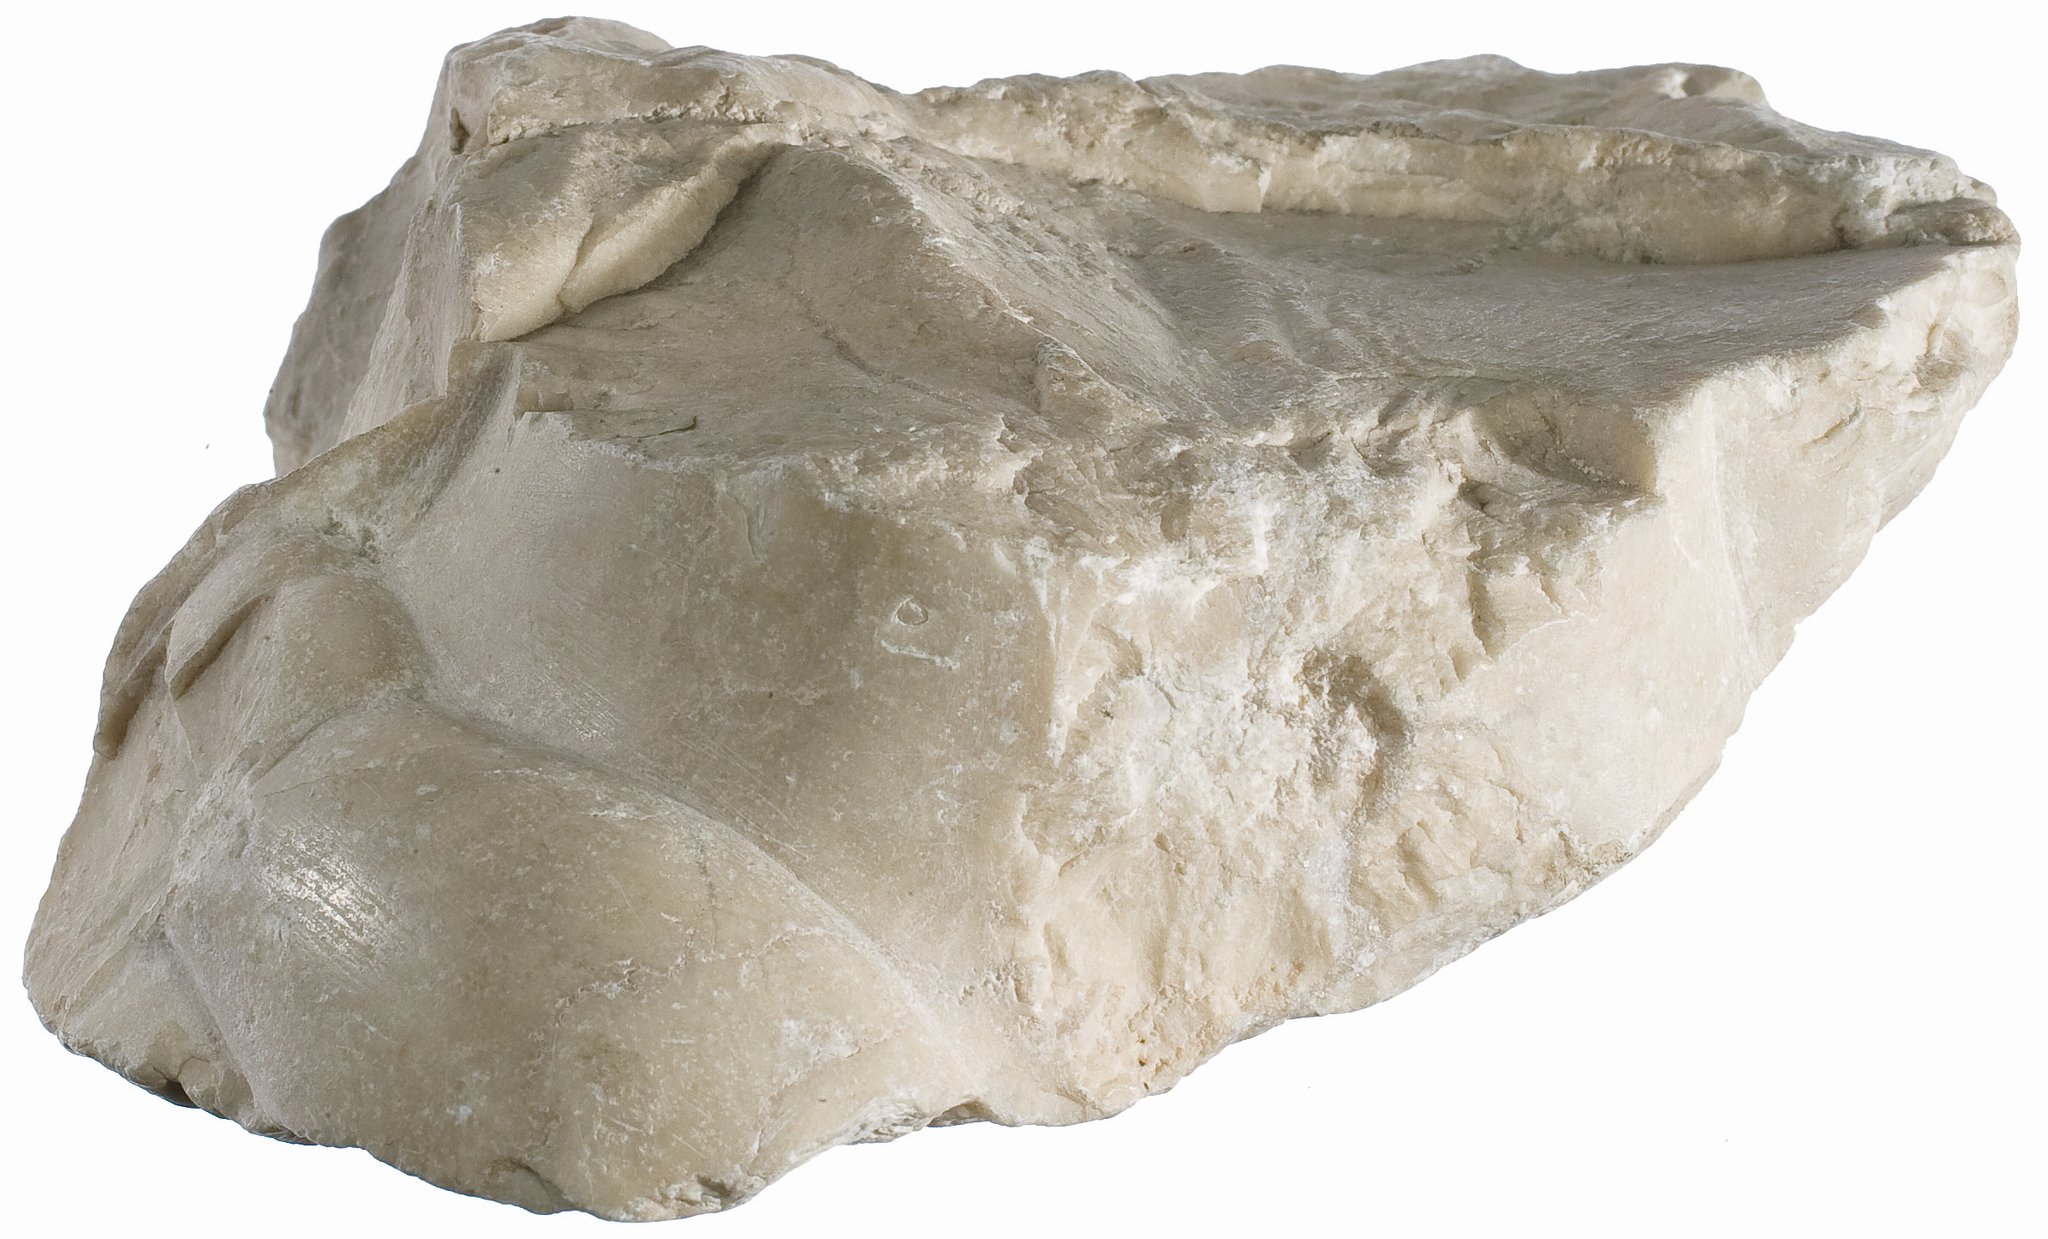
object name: foot fragment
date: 1353-1336 BCE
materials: limestone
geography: egypt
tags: feet